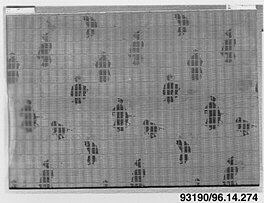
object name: piece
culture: japanese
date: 1701-1900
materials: silk